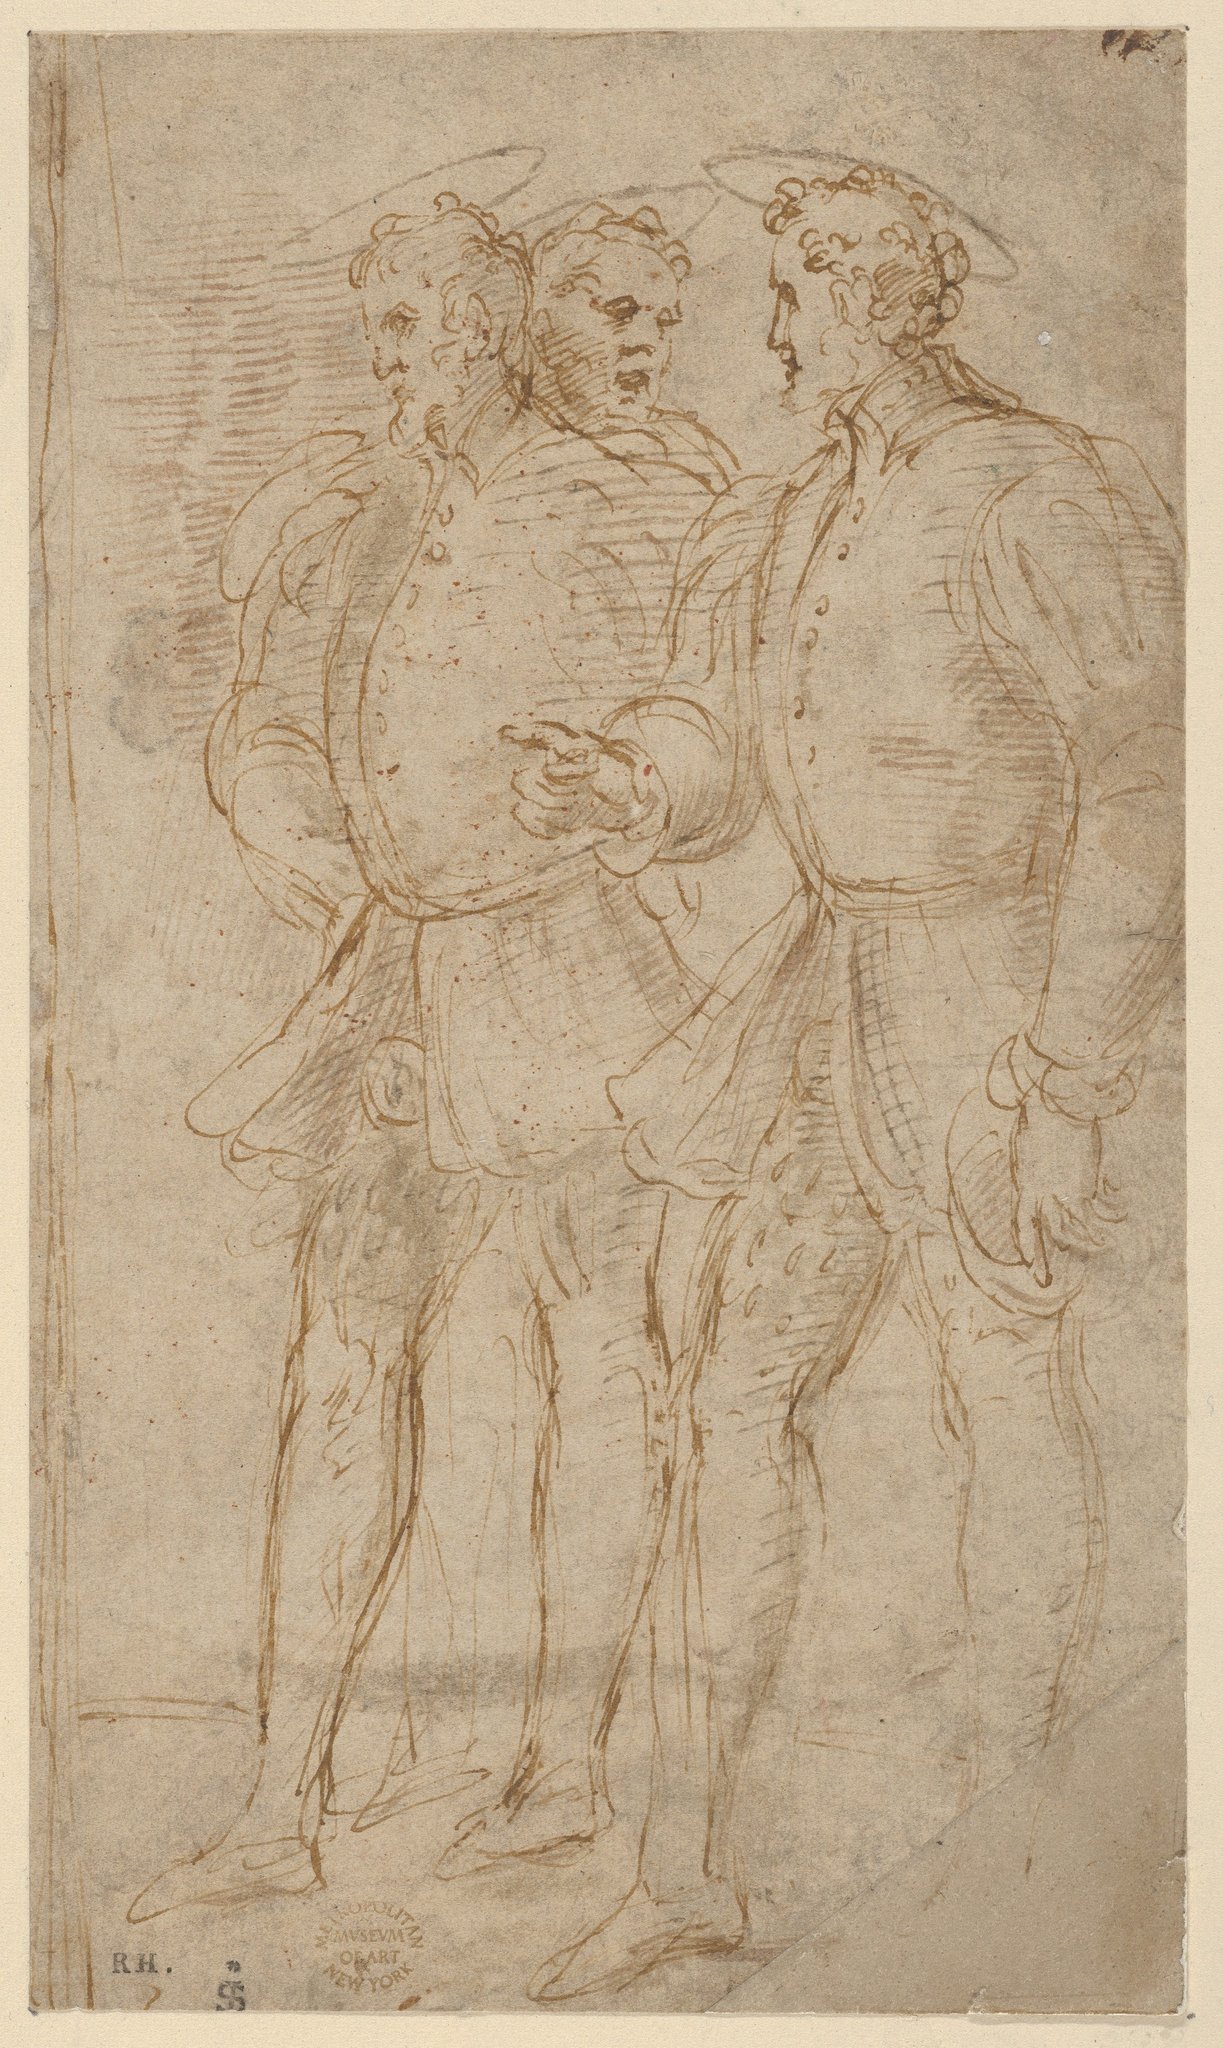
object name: drawing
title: Three Men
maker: anonymous, italian, florentine, 16th century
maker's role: artist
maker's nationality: italian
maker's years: 1500-1600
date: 1501-1600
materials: ink, paper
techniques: pen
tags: men